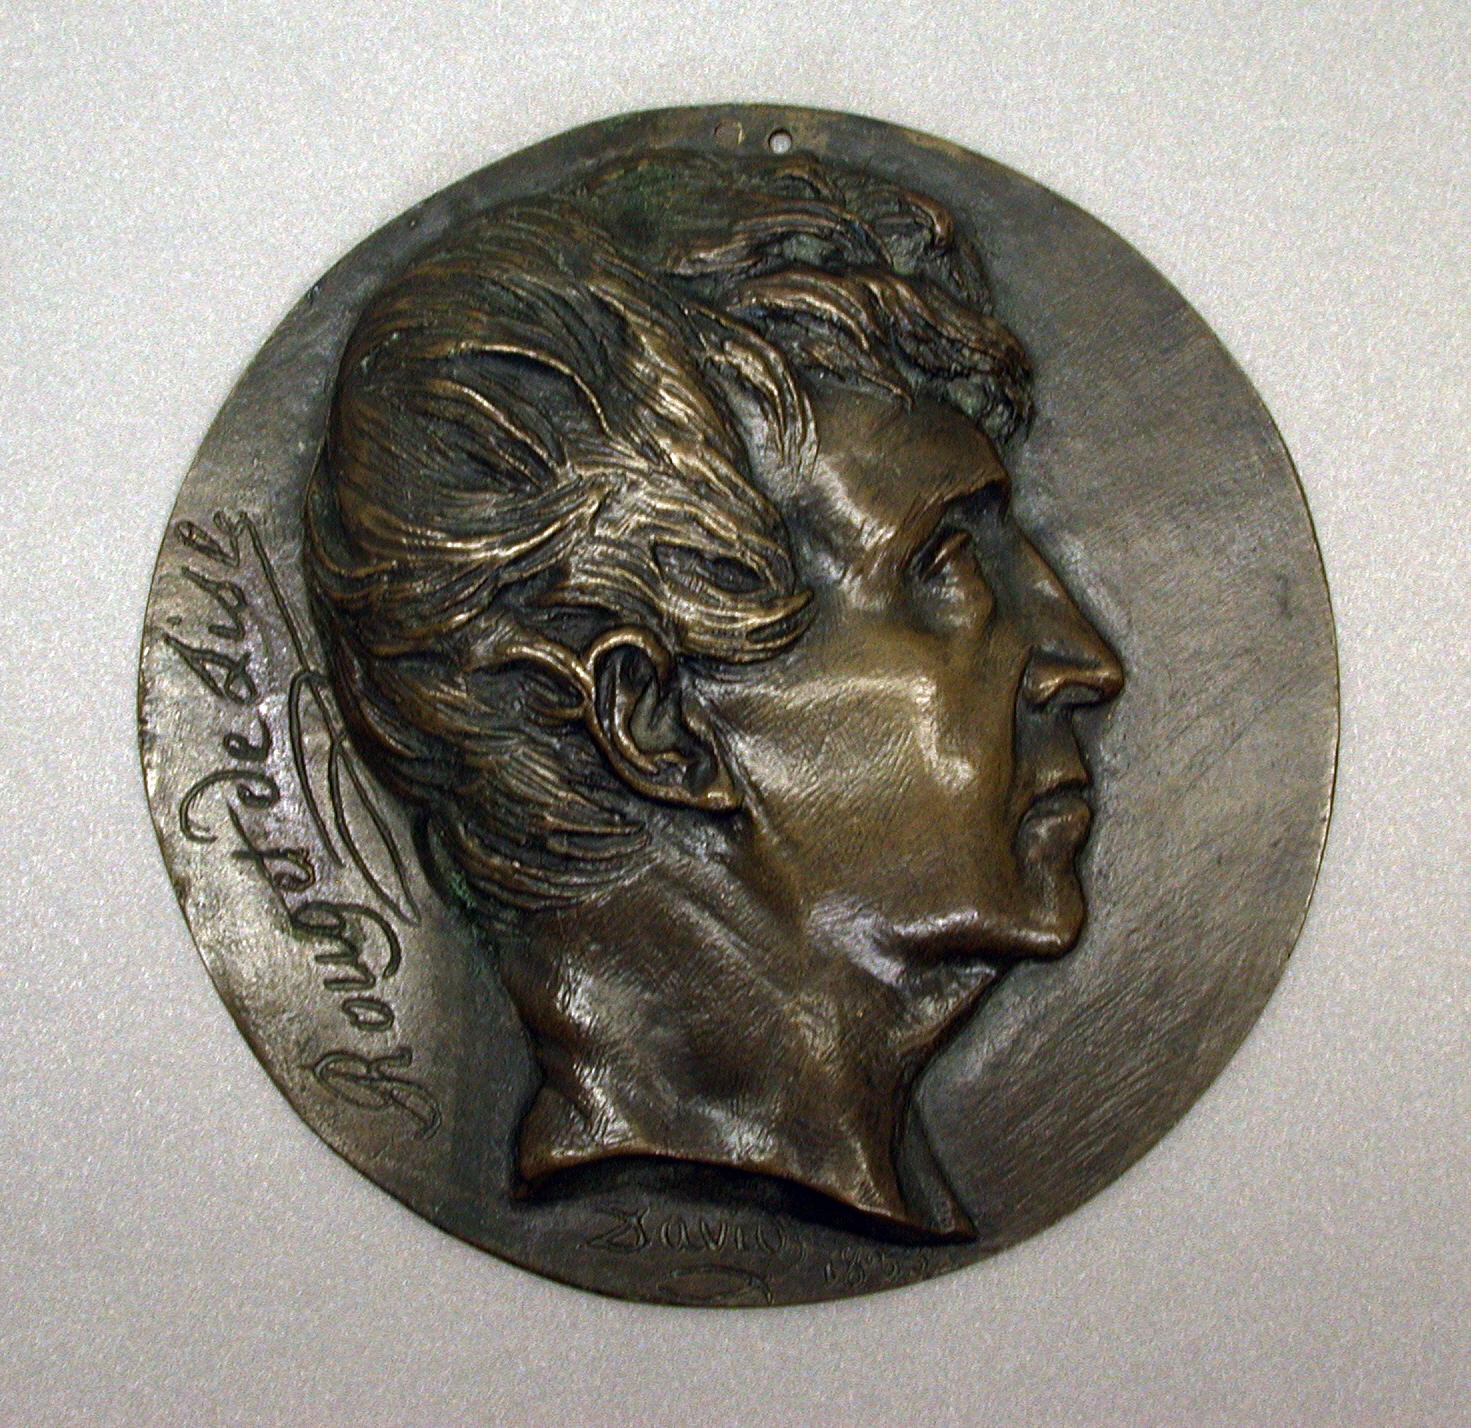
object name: medallion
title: Claude-Joseph Rouget de Lisle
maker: pierre jean david d'angers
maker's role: maker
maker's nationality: french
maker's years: 1788-1856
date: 1833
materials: bronze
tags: men,profiles